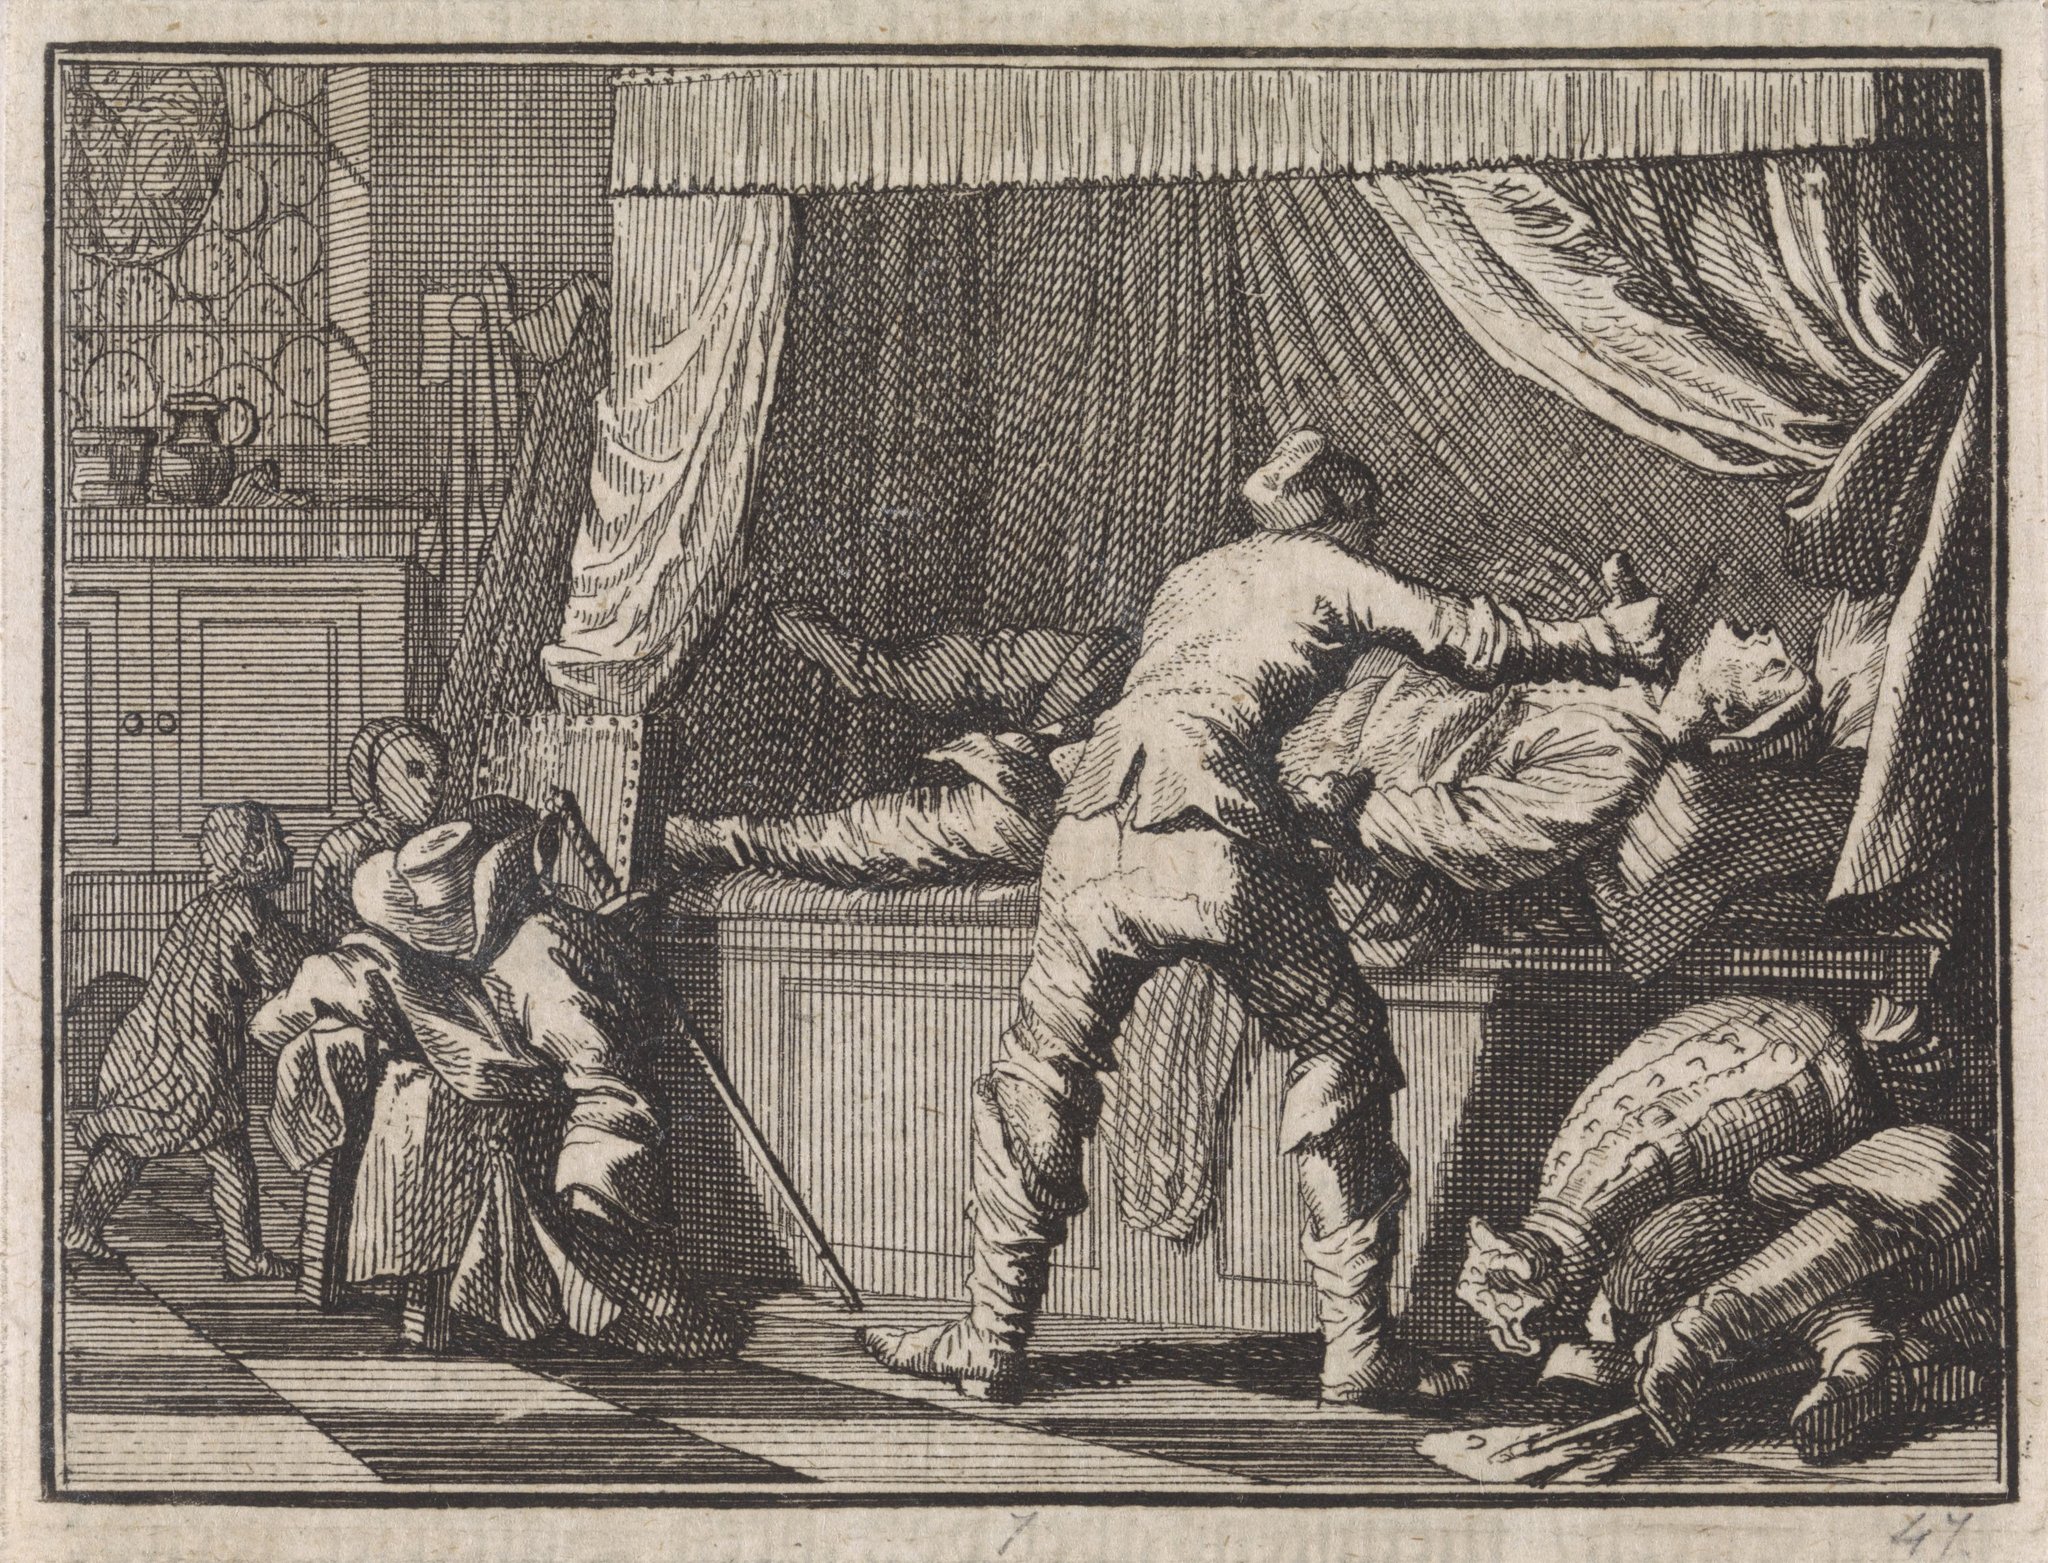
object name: print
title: Man steekt slaper met mes in de keel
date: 1704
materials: paper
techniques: etching, letterpress printing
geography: nuremberg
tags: murder, sleeping in bed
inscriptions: collector's mark: Lugt 2228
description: Illustratie vervangt Van Eeghen 3107 in sommige exemplaren van deze druk: Abraham a Sancta Clara. Heilsames Gemisch Gemasch, das ist: Allerley seltsame und verwunderliche Geschichten (...). Neurenberg: Christoph Weigel, 1704.